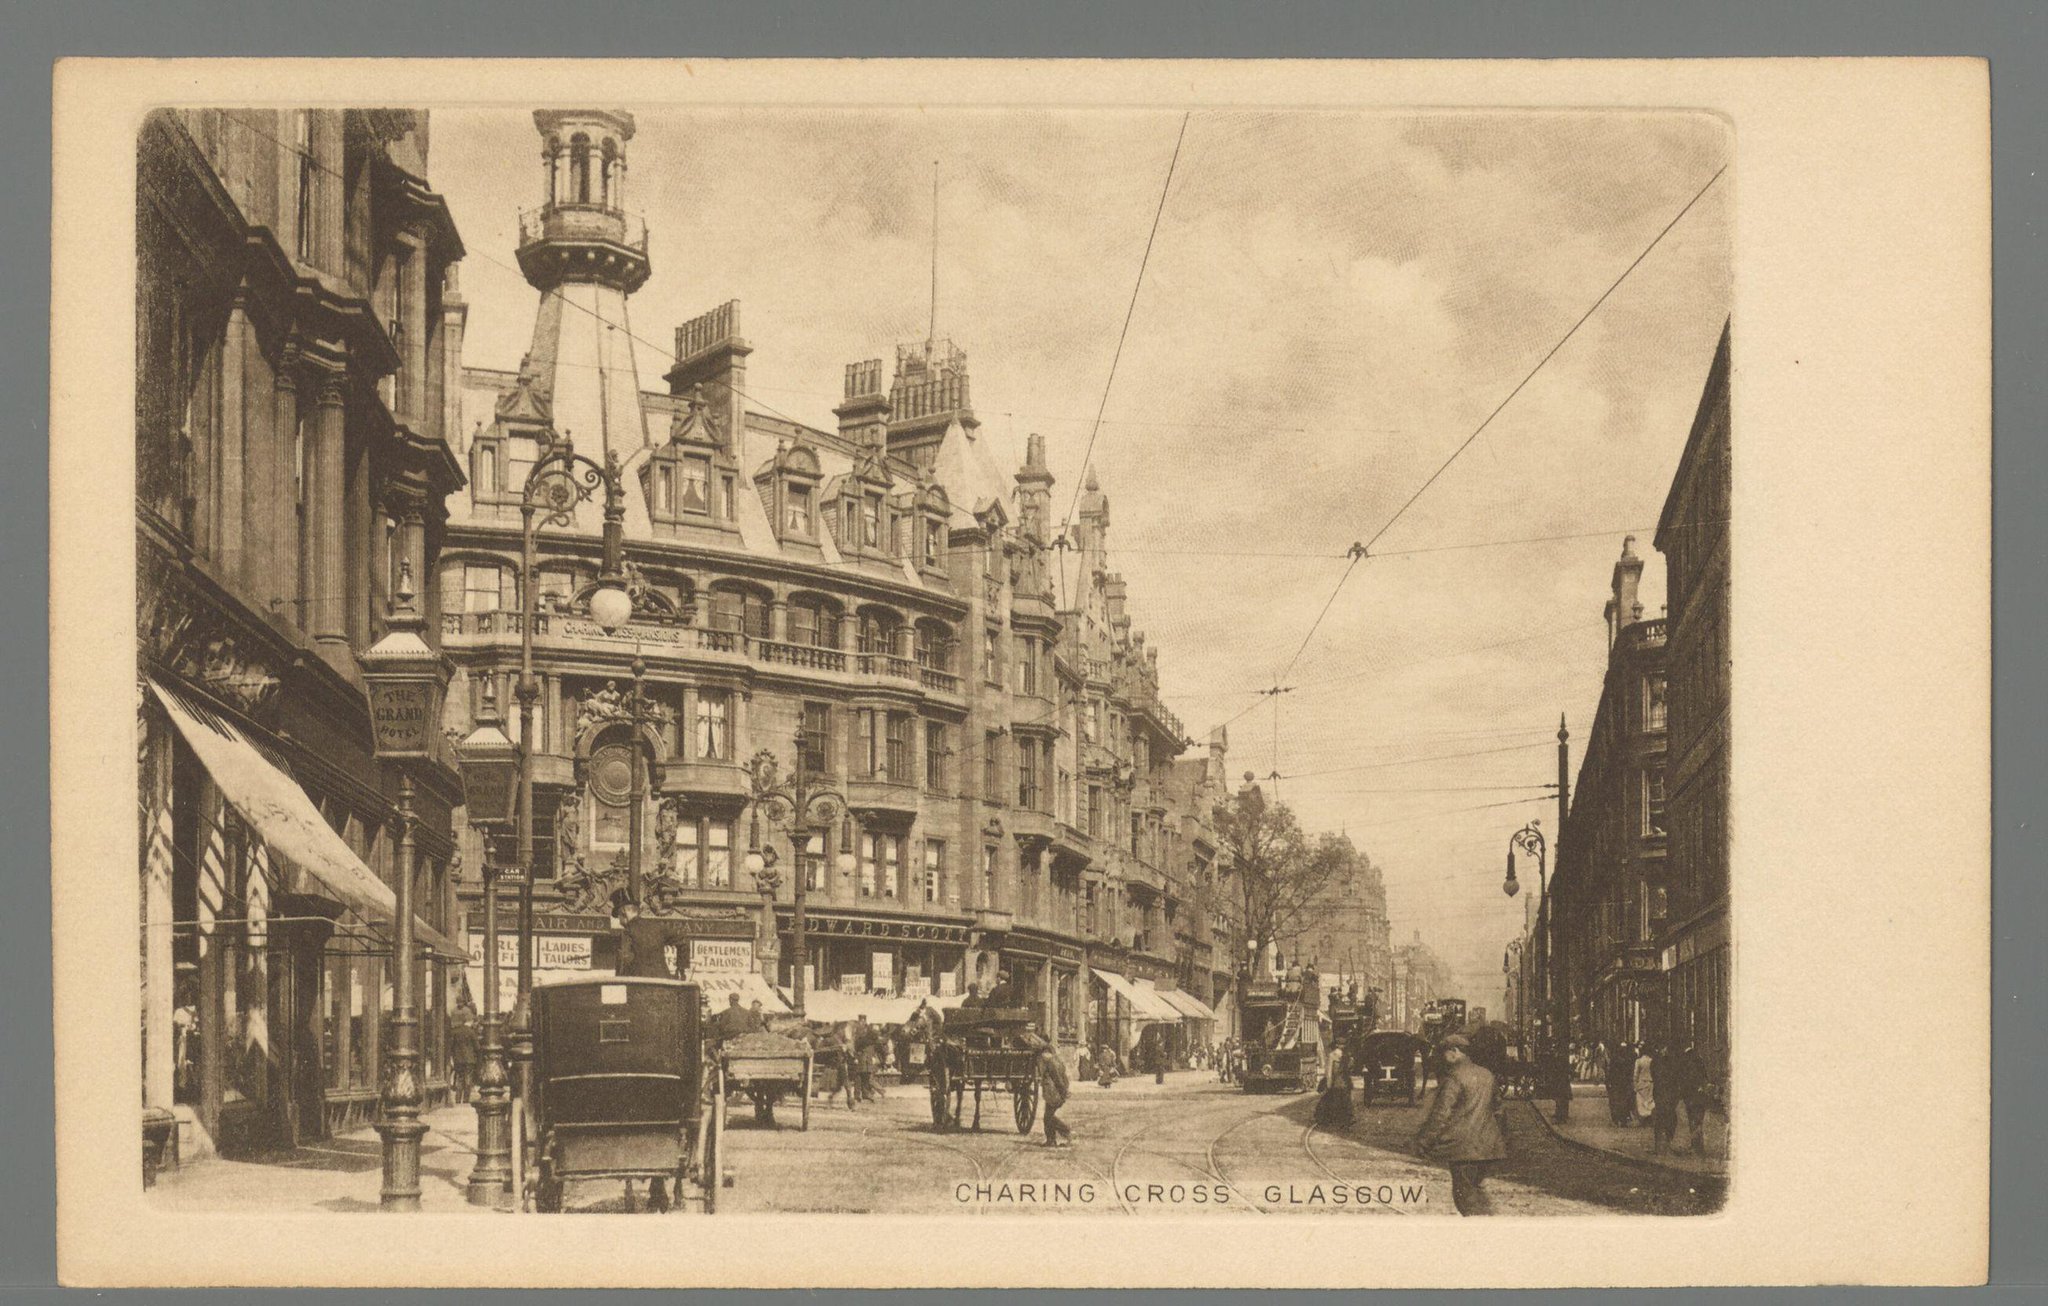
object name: photomechanical print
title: Charing Cross. Glasgow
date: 1894-1905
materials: cardboard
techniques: photoaquatint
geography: glasgow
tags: station; shelter (railway, tramway), street